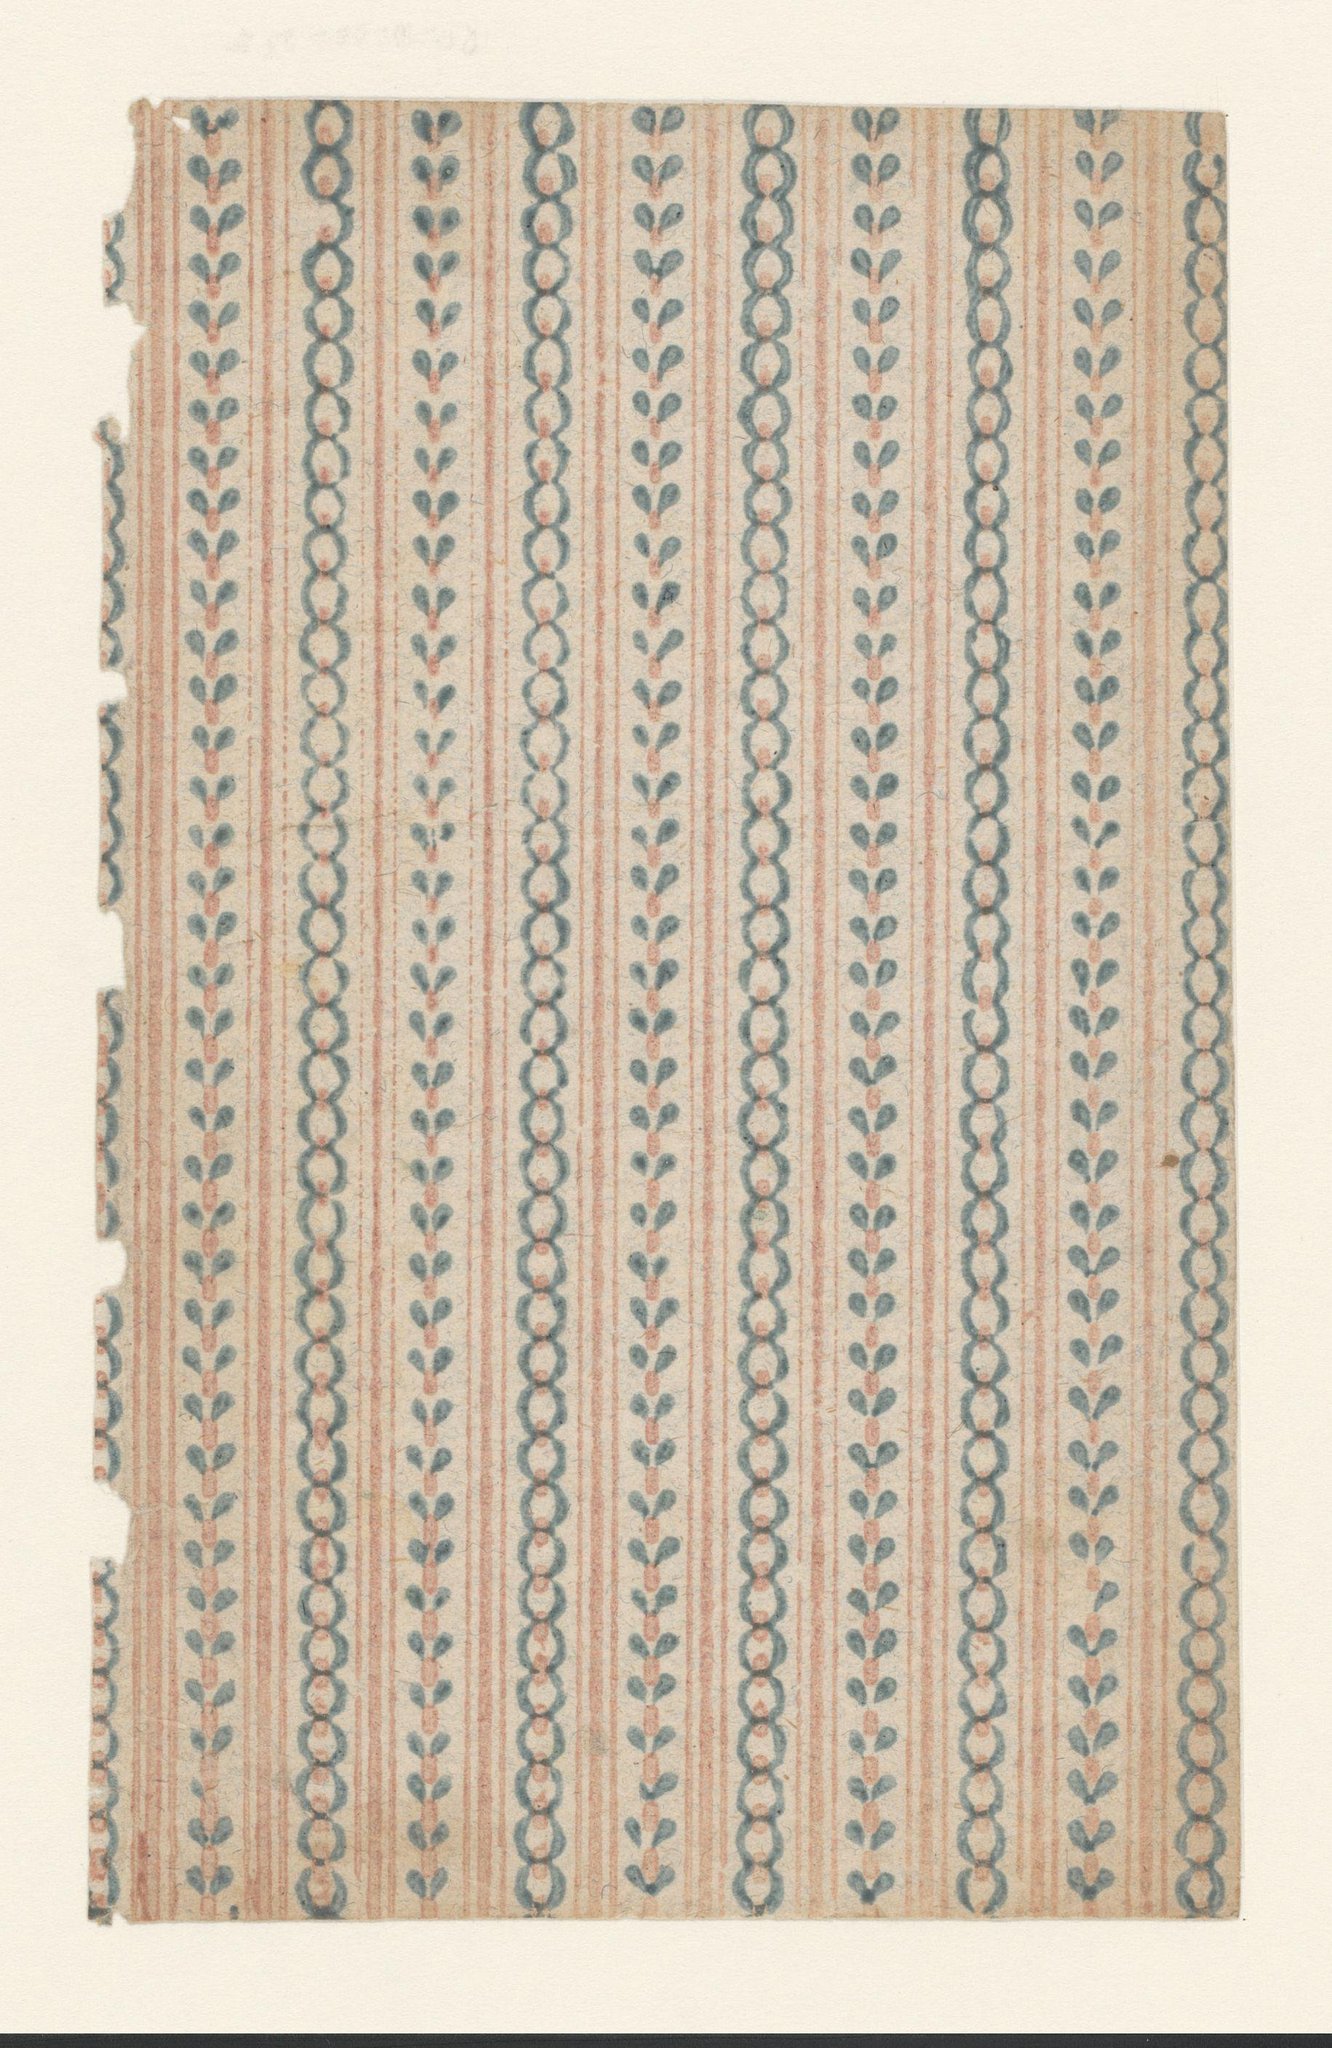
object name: printed paper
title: Blad met banenpatroon van drie lijnen en sierlijsten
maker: Anonymous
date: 1700-1850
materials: paper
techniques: printing block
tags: ornaments ~ art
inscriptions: collector's mark: Lugt 2228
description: Blad met banenpatroon van drie lijnen en sierlijsten met alternerend kralenmotief en met blaadjesmotief.